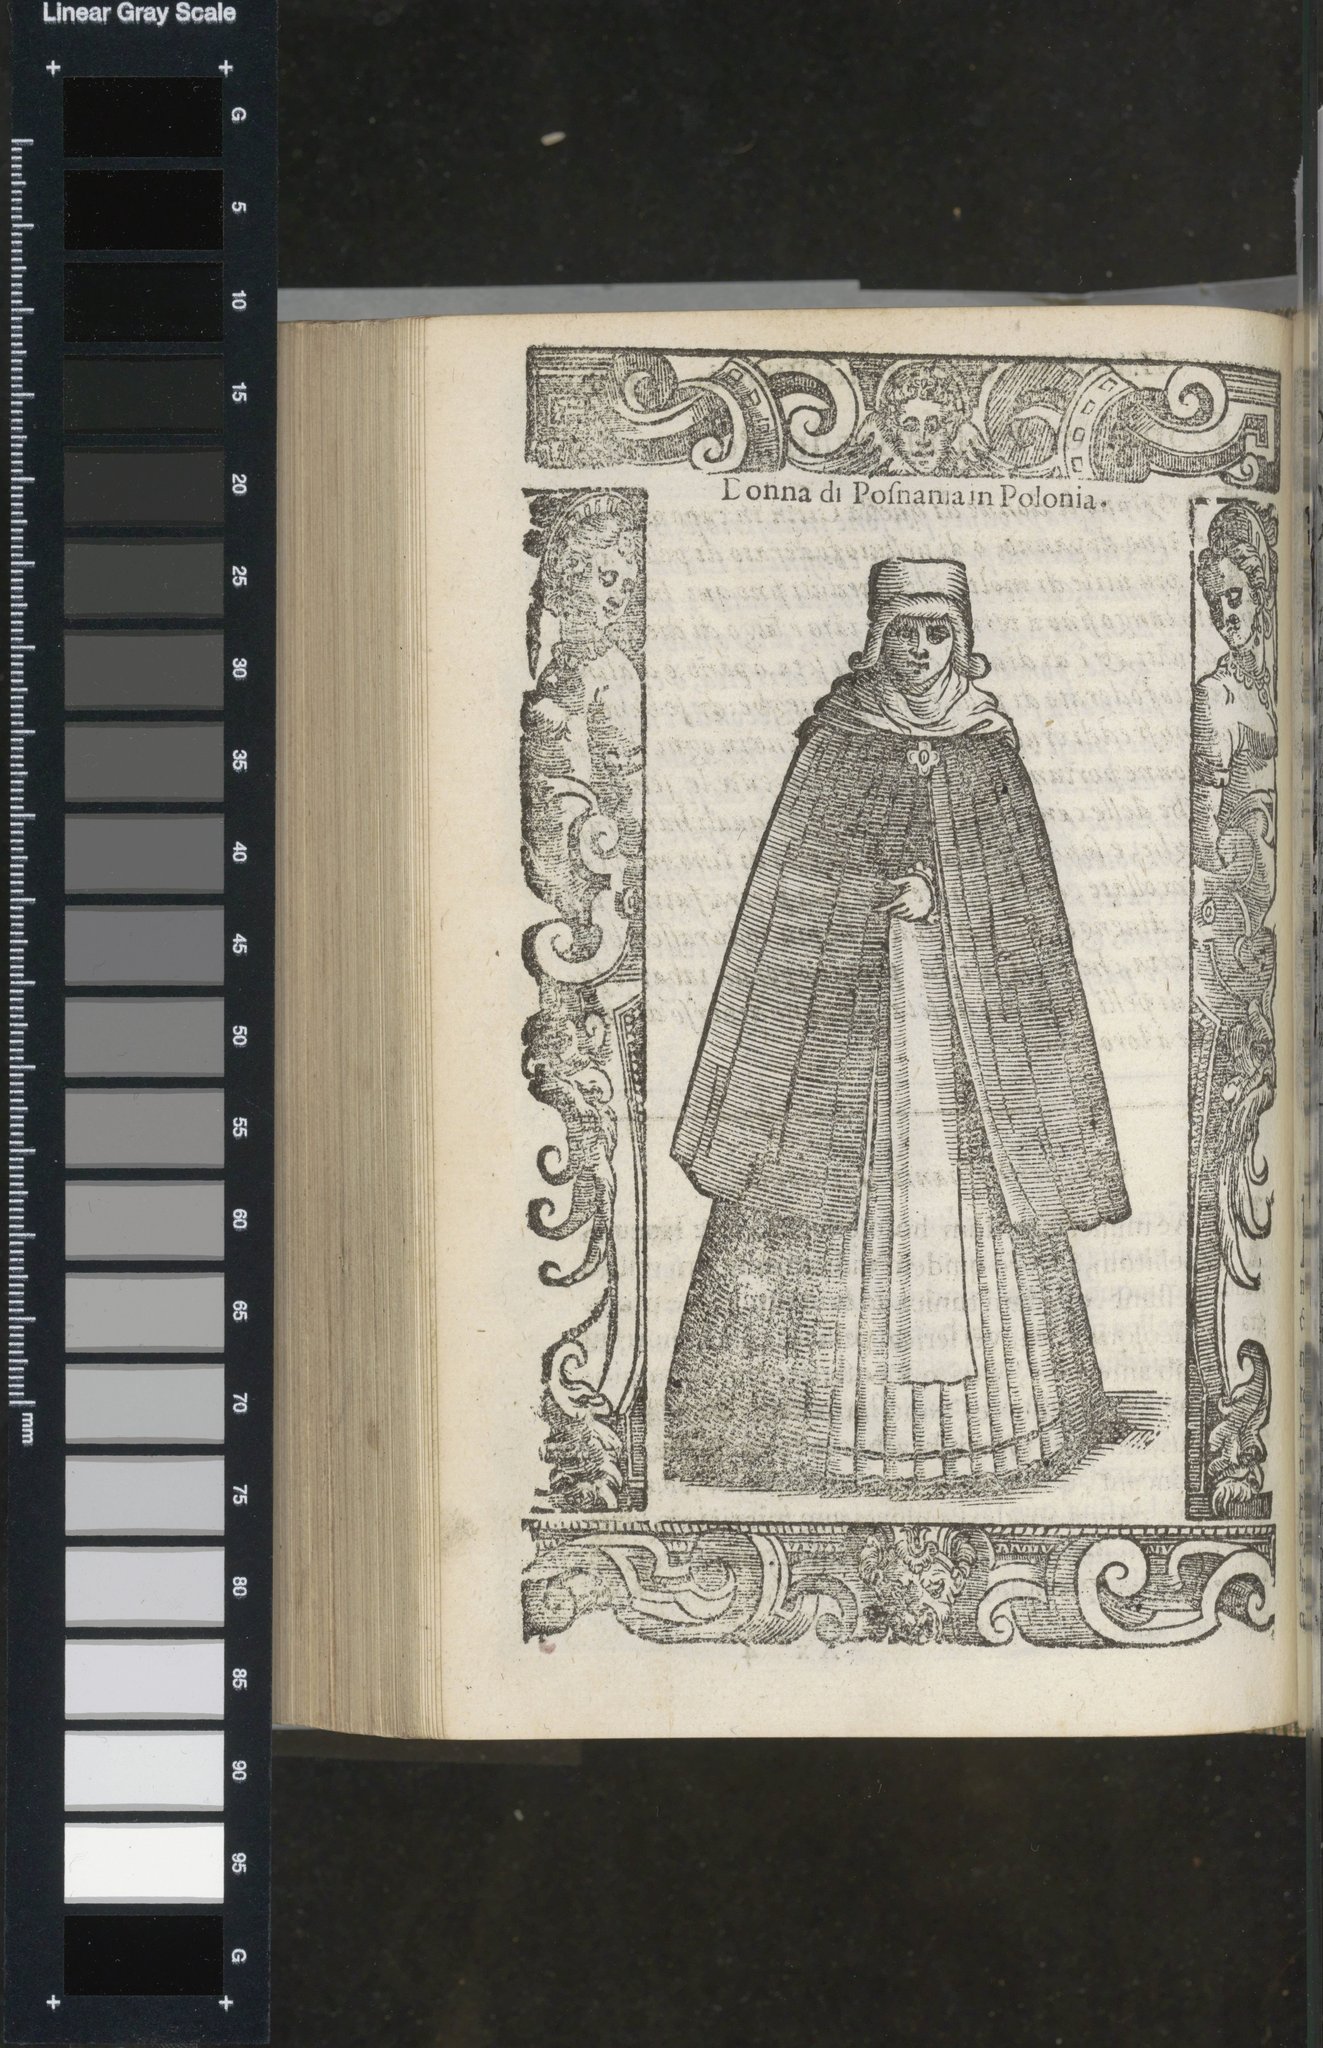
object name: costume print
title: Habiti antichi, et moderni di tutto il mondo...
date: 1598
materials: paper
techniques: woodcut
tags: fashion plates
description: Vrouw uit Poznan in Polen, waar ‘de vrouwen heel anders zijn dan elders’. Cape tot knielengte over een lang geplooid overkleed. Kapje met oorkleppen.